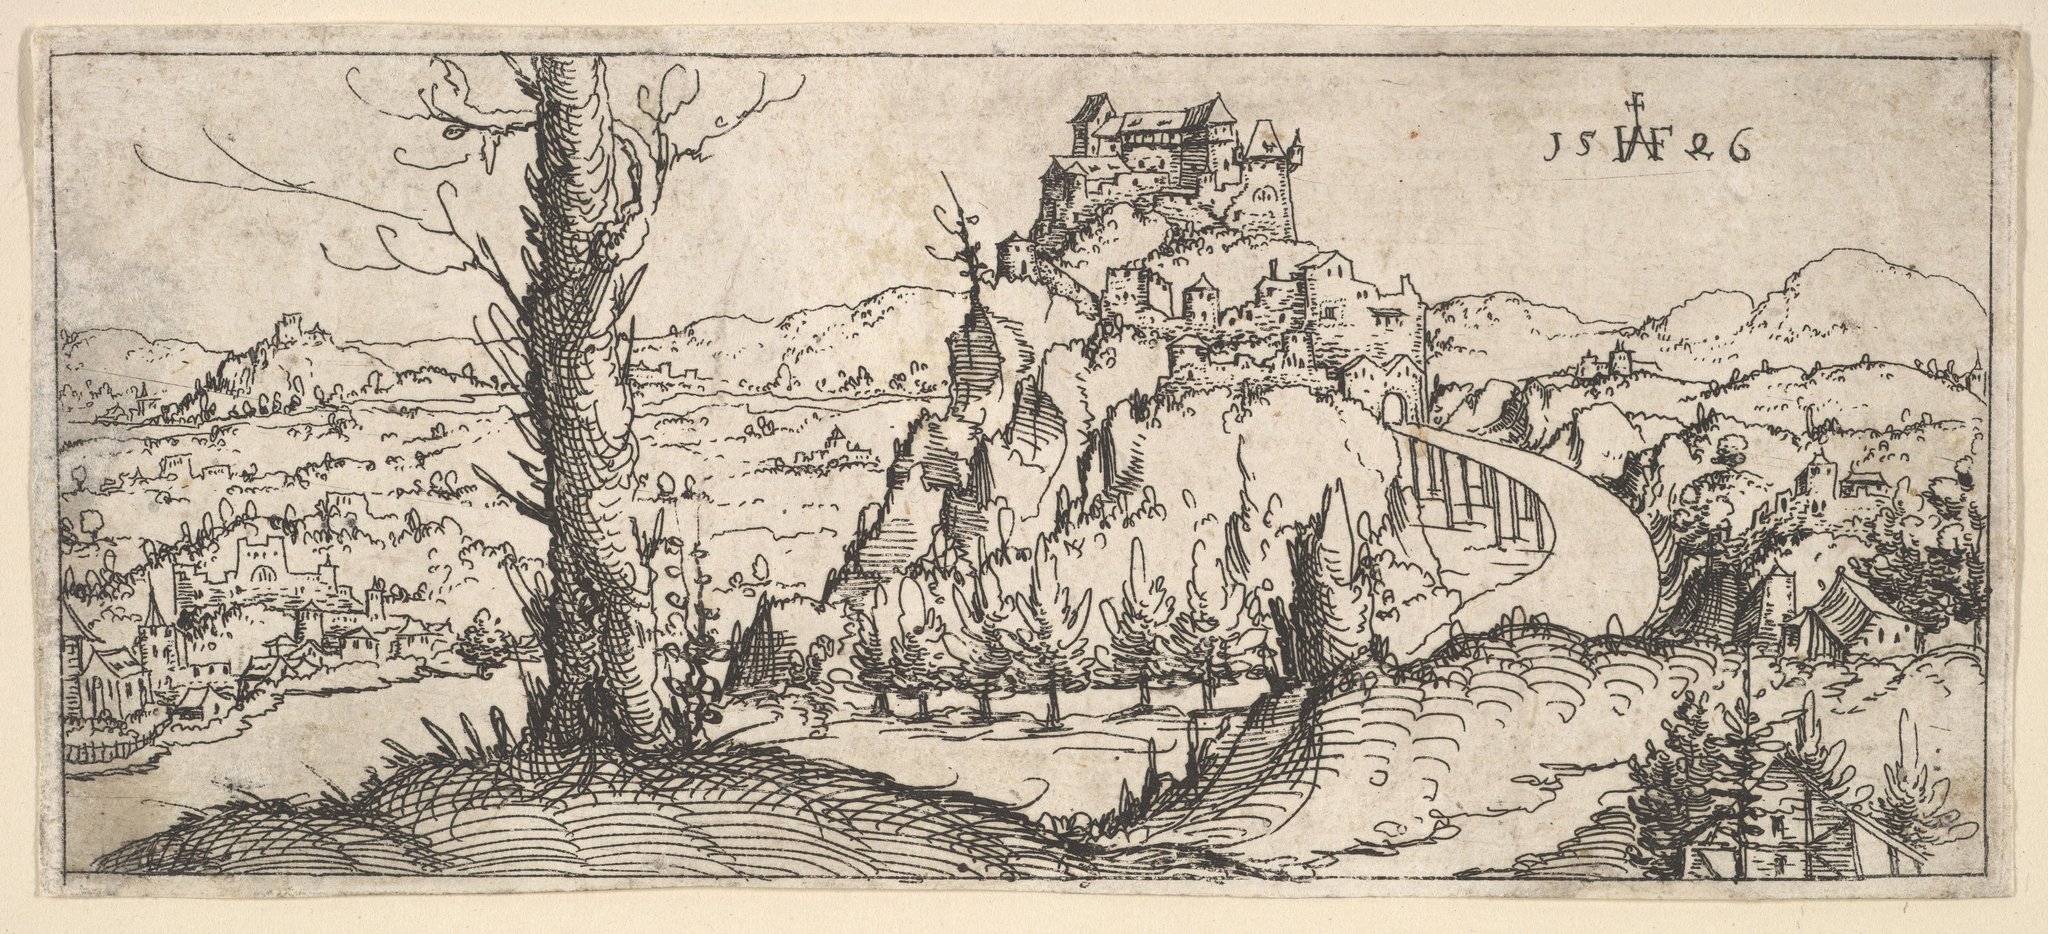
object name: print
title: Landscape with High Rocks and Fortresses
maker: augustin hirschvogel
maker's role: artist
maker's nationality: german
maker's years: 1503-1553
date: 1546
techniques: etching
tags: fortification,landscapes